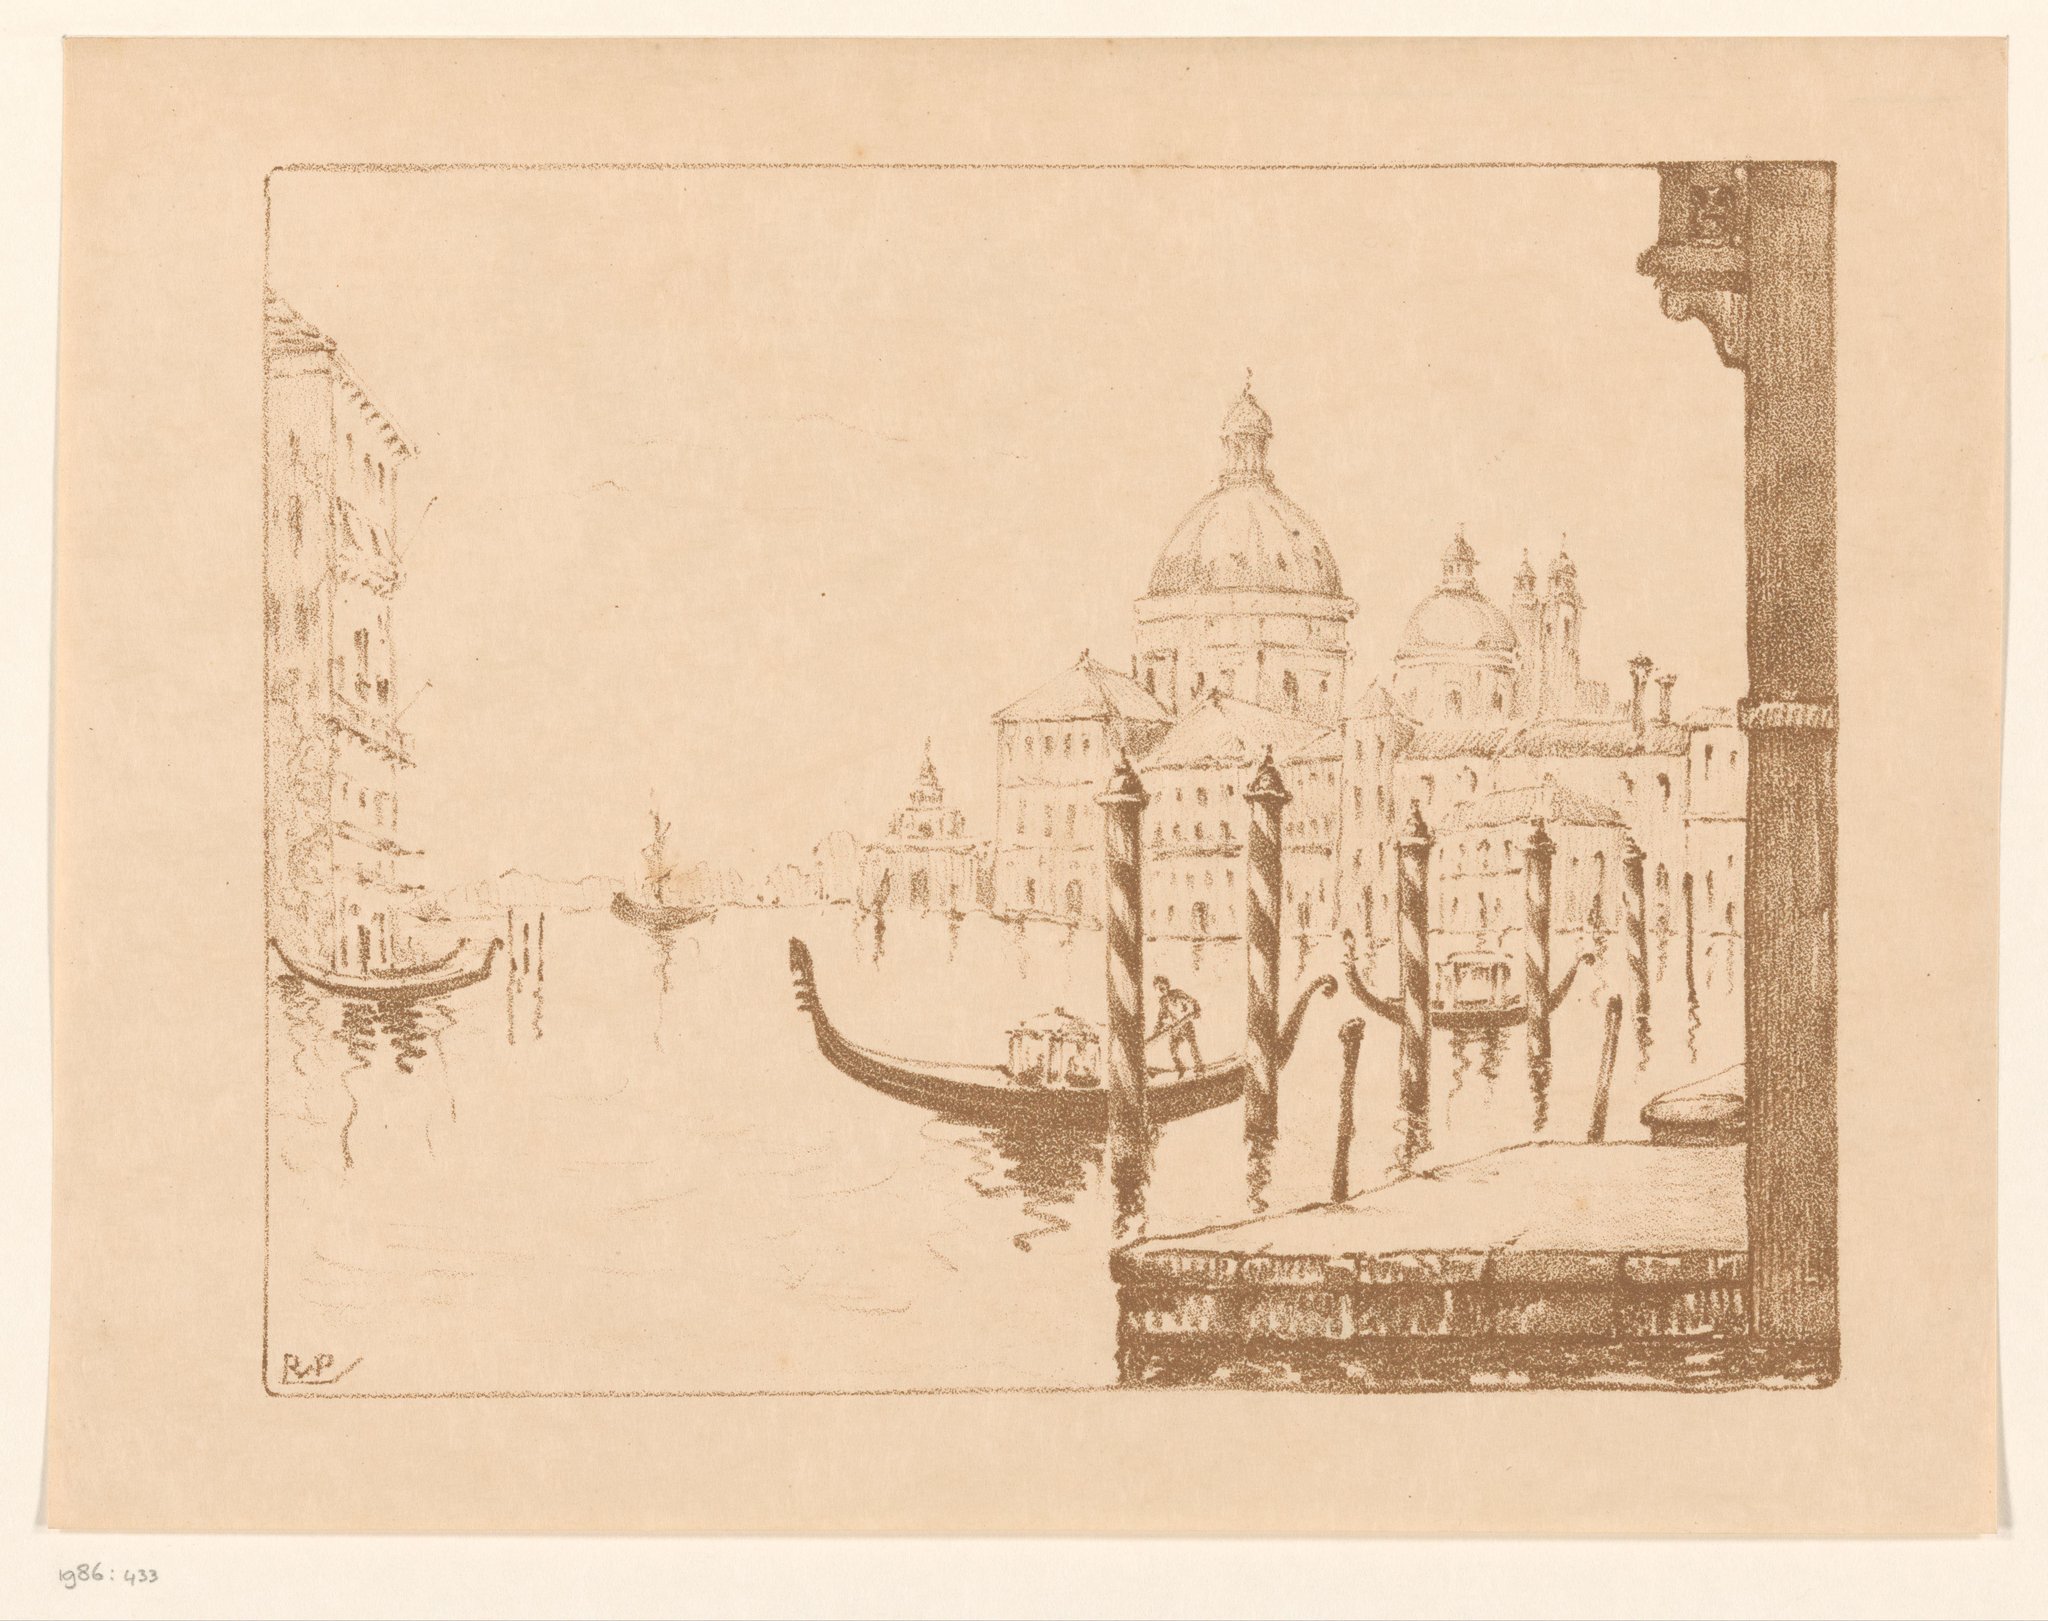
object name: print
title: Gezicht op het Canal Grande en de Santa Maria della Salute, te Venetië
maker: reinier willem petrus de vries (1874-1953)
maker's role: draughtsman, print maker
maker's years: 1874-1953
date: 1884-1952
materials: paper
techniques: lithograph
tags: church (exterior), canals, waters (in city), gondola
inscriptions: collector's mark: Lugt 2228